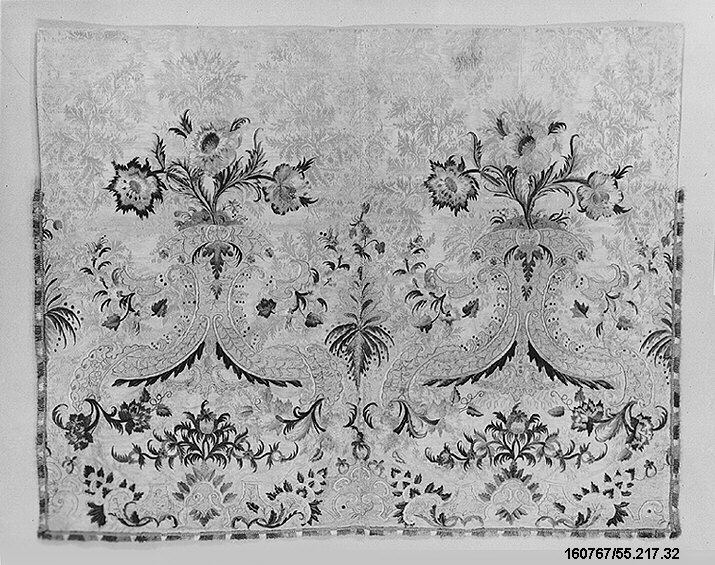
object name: border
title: Piece of a dress border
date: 1701-1750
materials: silk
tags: flowers